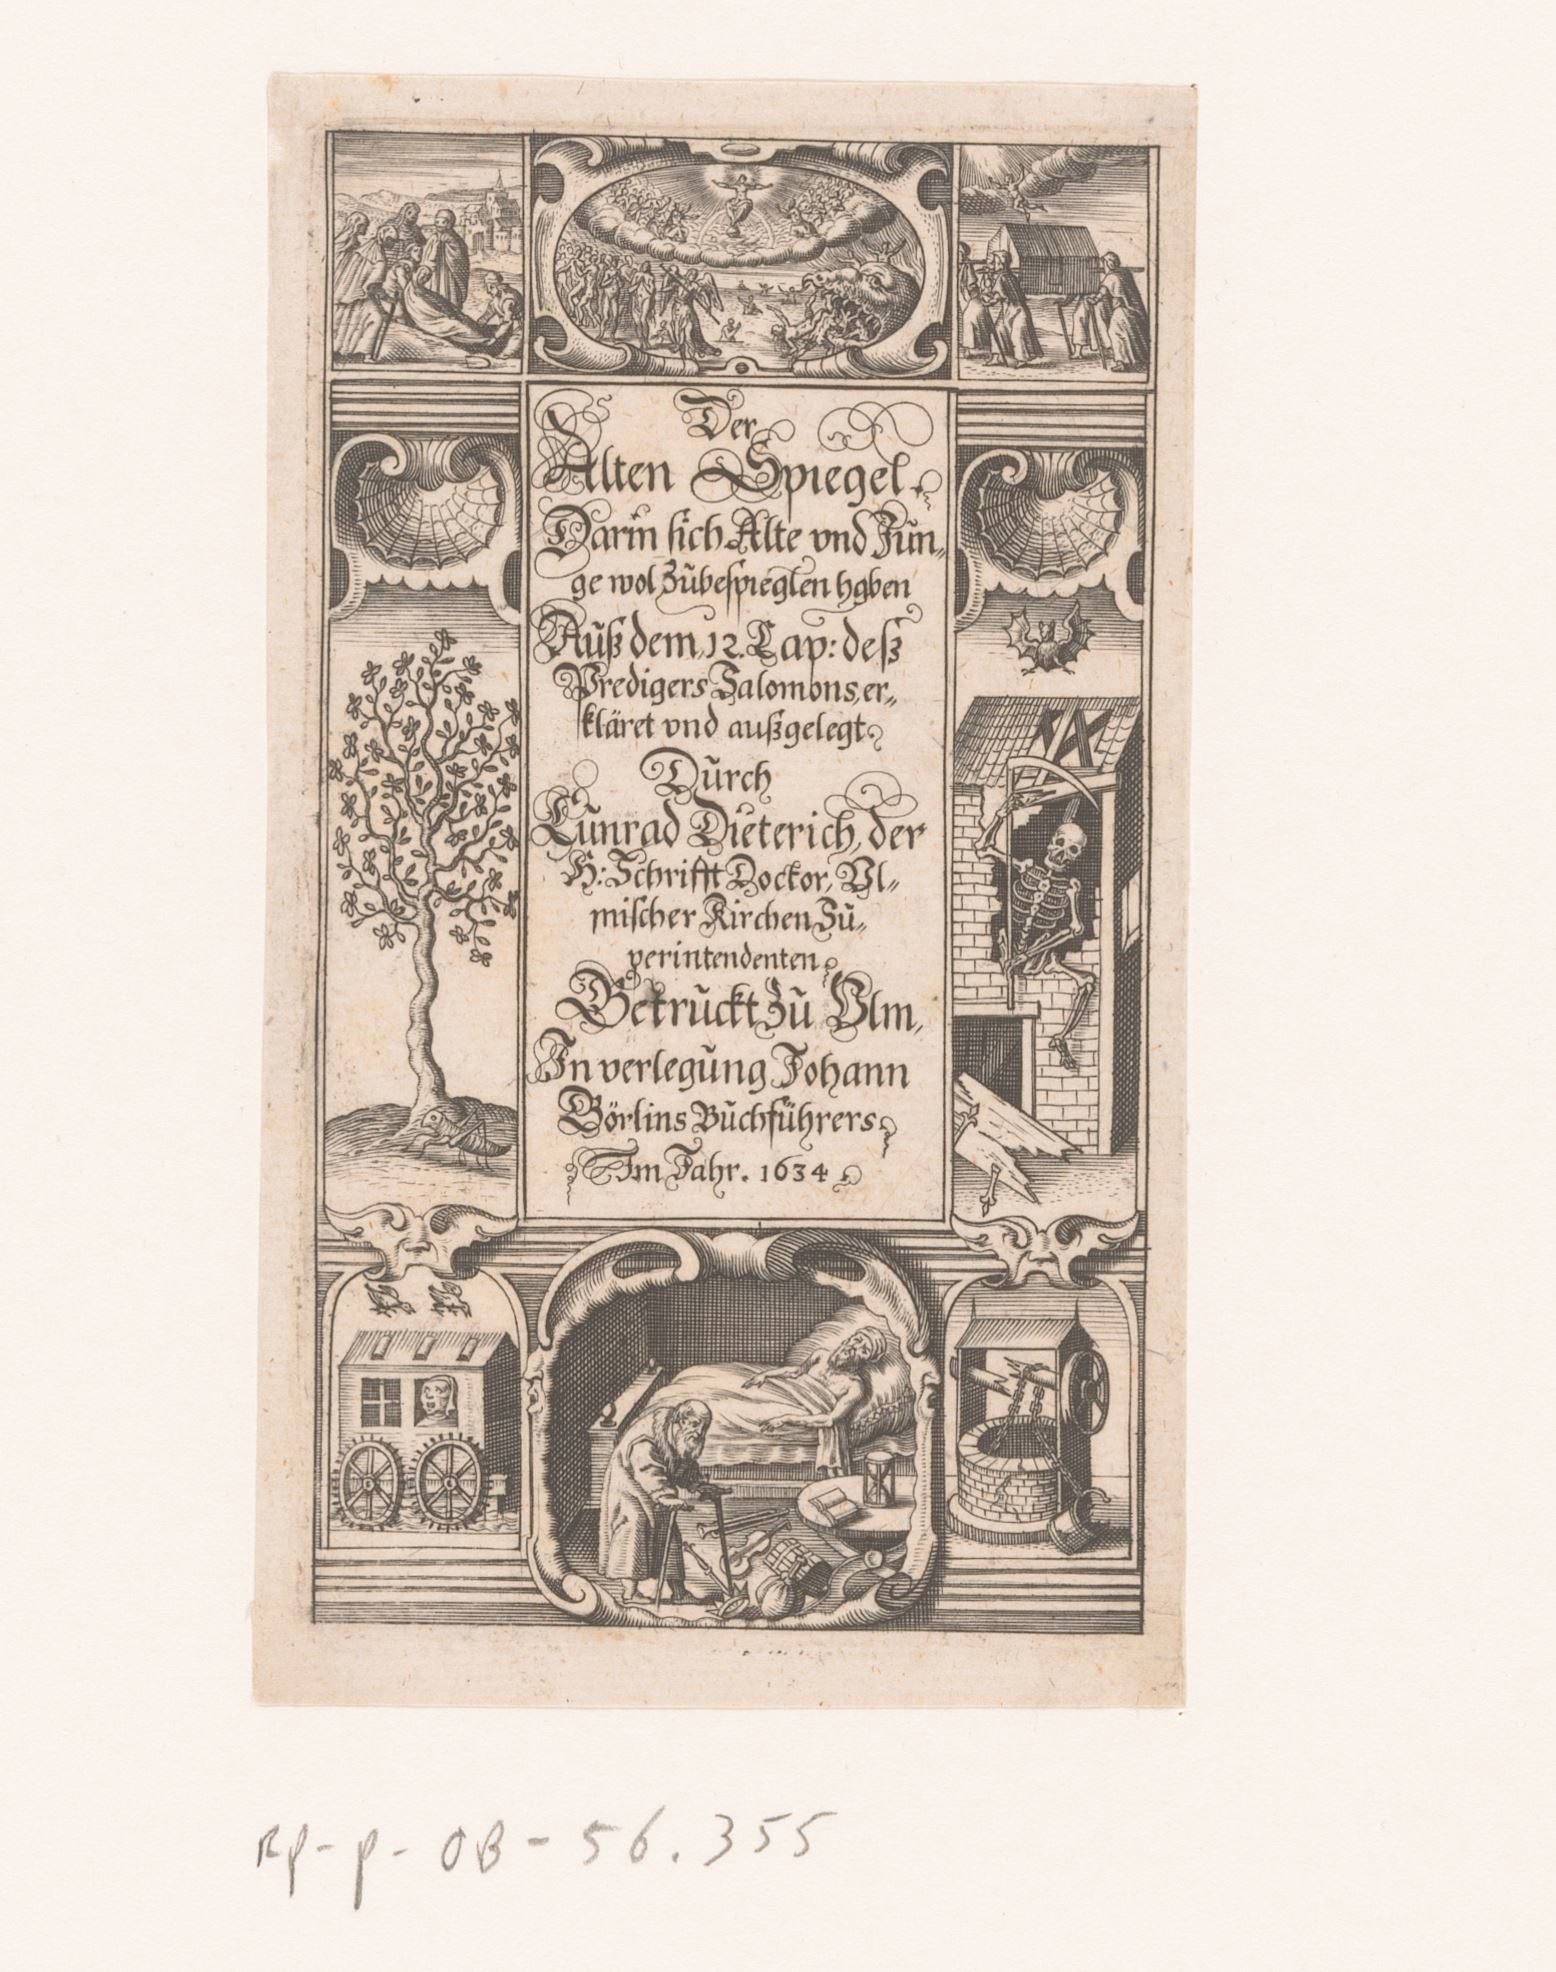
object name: print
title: Allegorie op oude leeftijd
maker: Anonymous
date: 1634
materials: paper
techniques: engraving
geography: germany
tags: old age, 'senectus'; 'vecchiezza' (ripa), title-page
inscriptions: collector's mark: Lugt 2228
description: Prent afkomstig uit: Meder, Johann Sebastian. Der Alten Spiegel. Ulm: Johann Görlin, 1634.